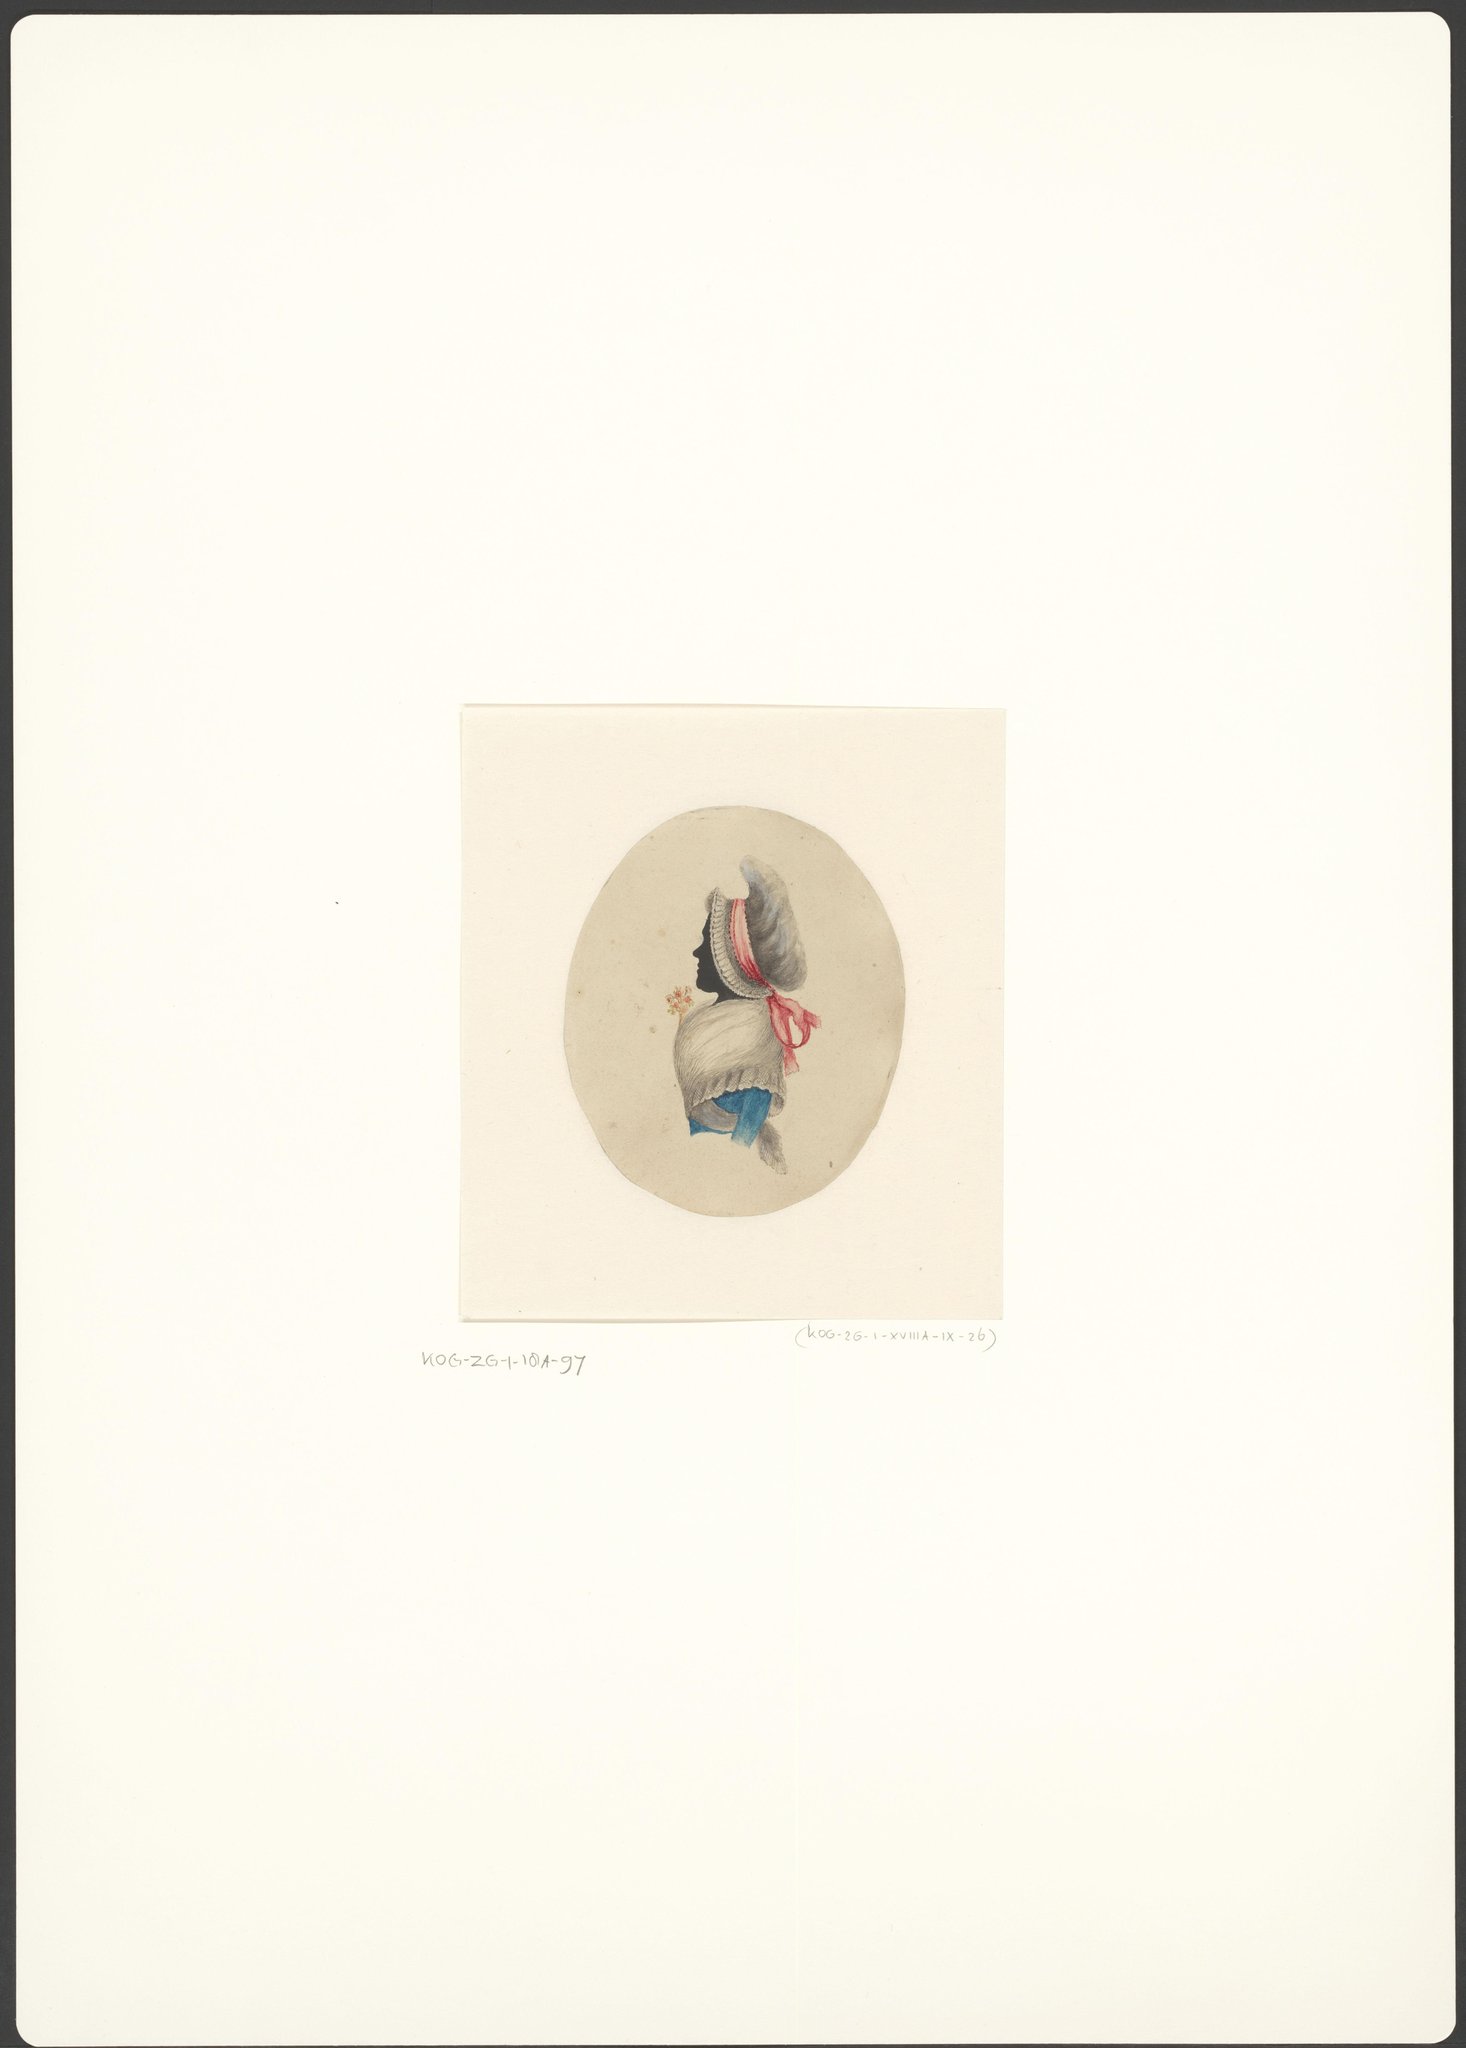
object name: cut paper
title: Silhouetportret van een onbekende vrouw met hoge muts en omslag doek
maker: Anonymous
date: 1775-1849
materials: ink, paper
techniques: pen, snipping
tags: face (+ sideview, profile), historical persons not known by name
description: Zij draagt een hoge muts met een lang lint waarvan de strik op haar rug valt. Verder een japon met omslagdoek en op haar borst een klein boeket. Onderwerpsrubrieken binnen de Atlas Zeden en Gewoonten: Schoone kunsten, Silhouetportretten.